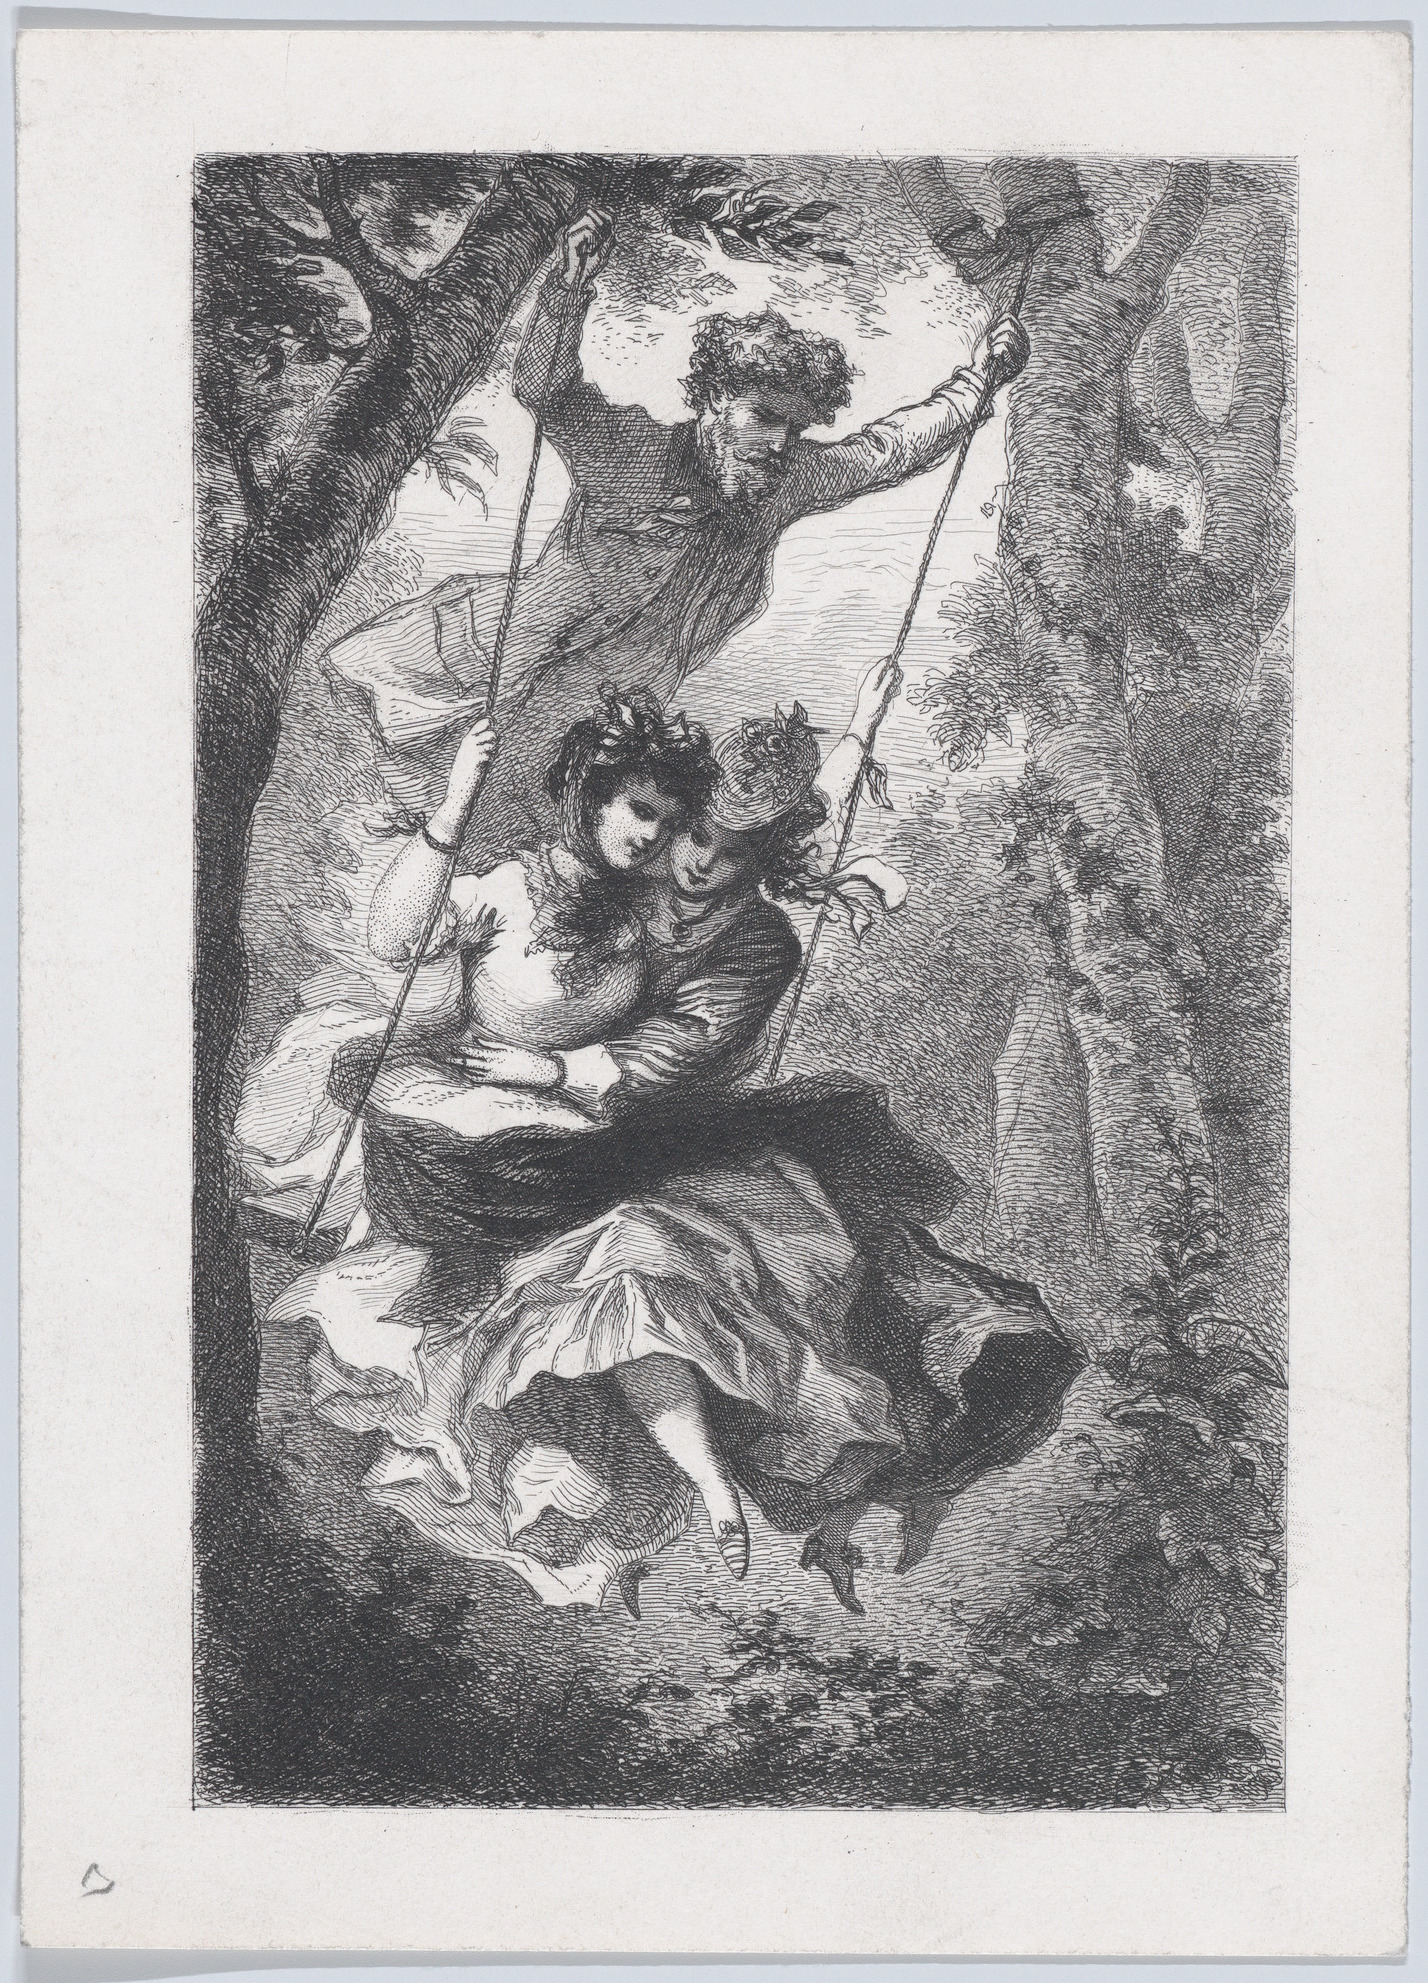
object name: print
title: A Man Pushing Two Women on a Swing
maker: j. cariven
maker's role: artist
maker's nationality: french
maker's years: 1864-1880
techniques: etching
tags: men,women